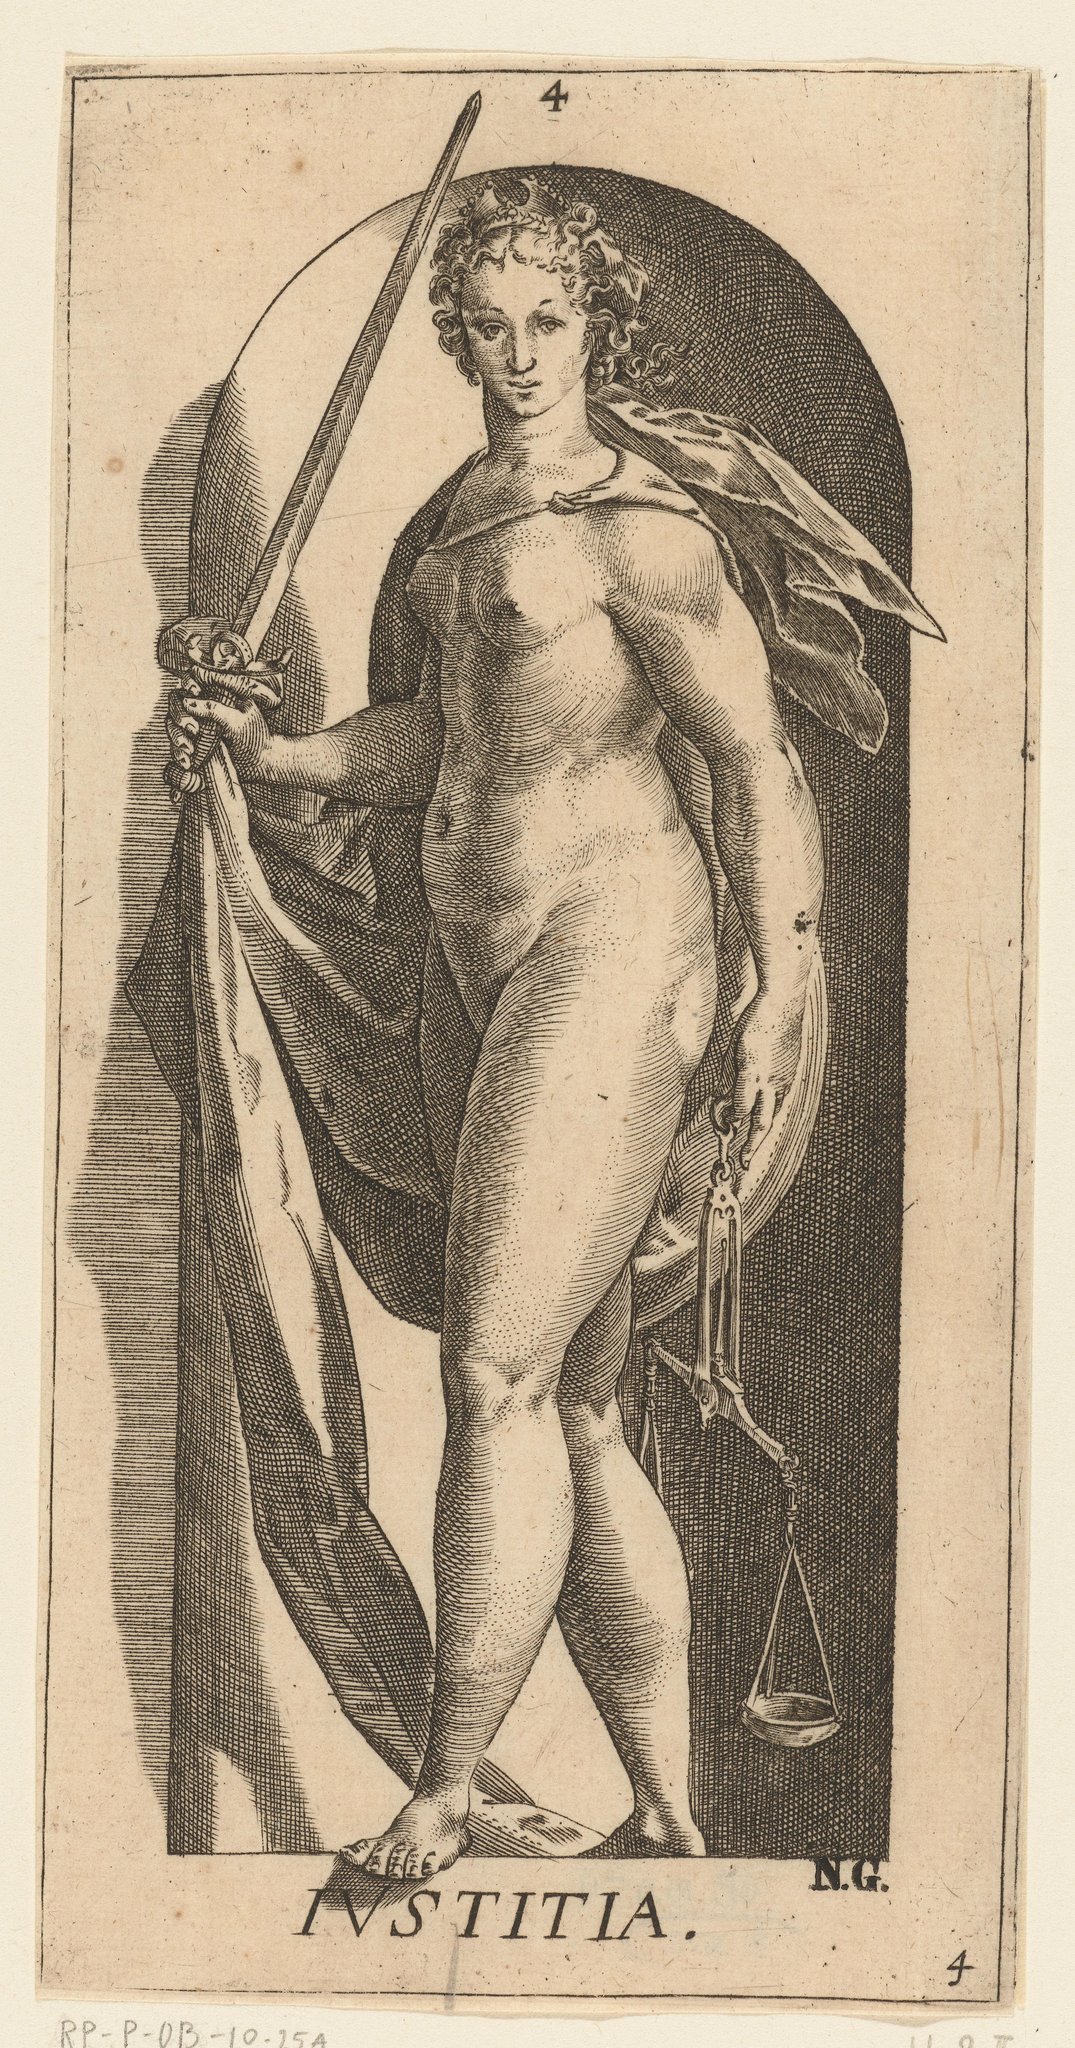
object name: print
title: De zeven deugden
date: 1578-1582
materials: paper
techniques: engraving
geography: amsterdam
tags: justice, 'justitia'; 'giustitia divina' (ripa) ~ one of the four cardinal virtues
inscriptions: collector's mark: Lugt 1967, collector's mark: Lugt 2228a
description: De Rechtvaardigheid, voorgesteld als een vrijwel naakte vrouw met een zwaard in de ene hand en een weegschaal in de andere. Deze prent is onderdeel van een prentserie van de zeven deugden, elk in de gedaante van een vrouwenfiguur met attributen, staand in een nis.